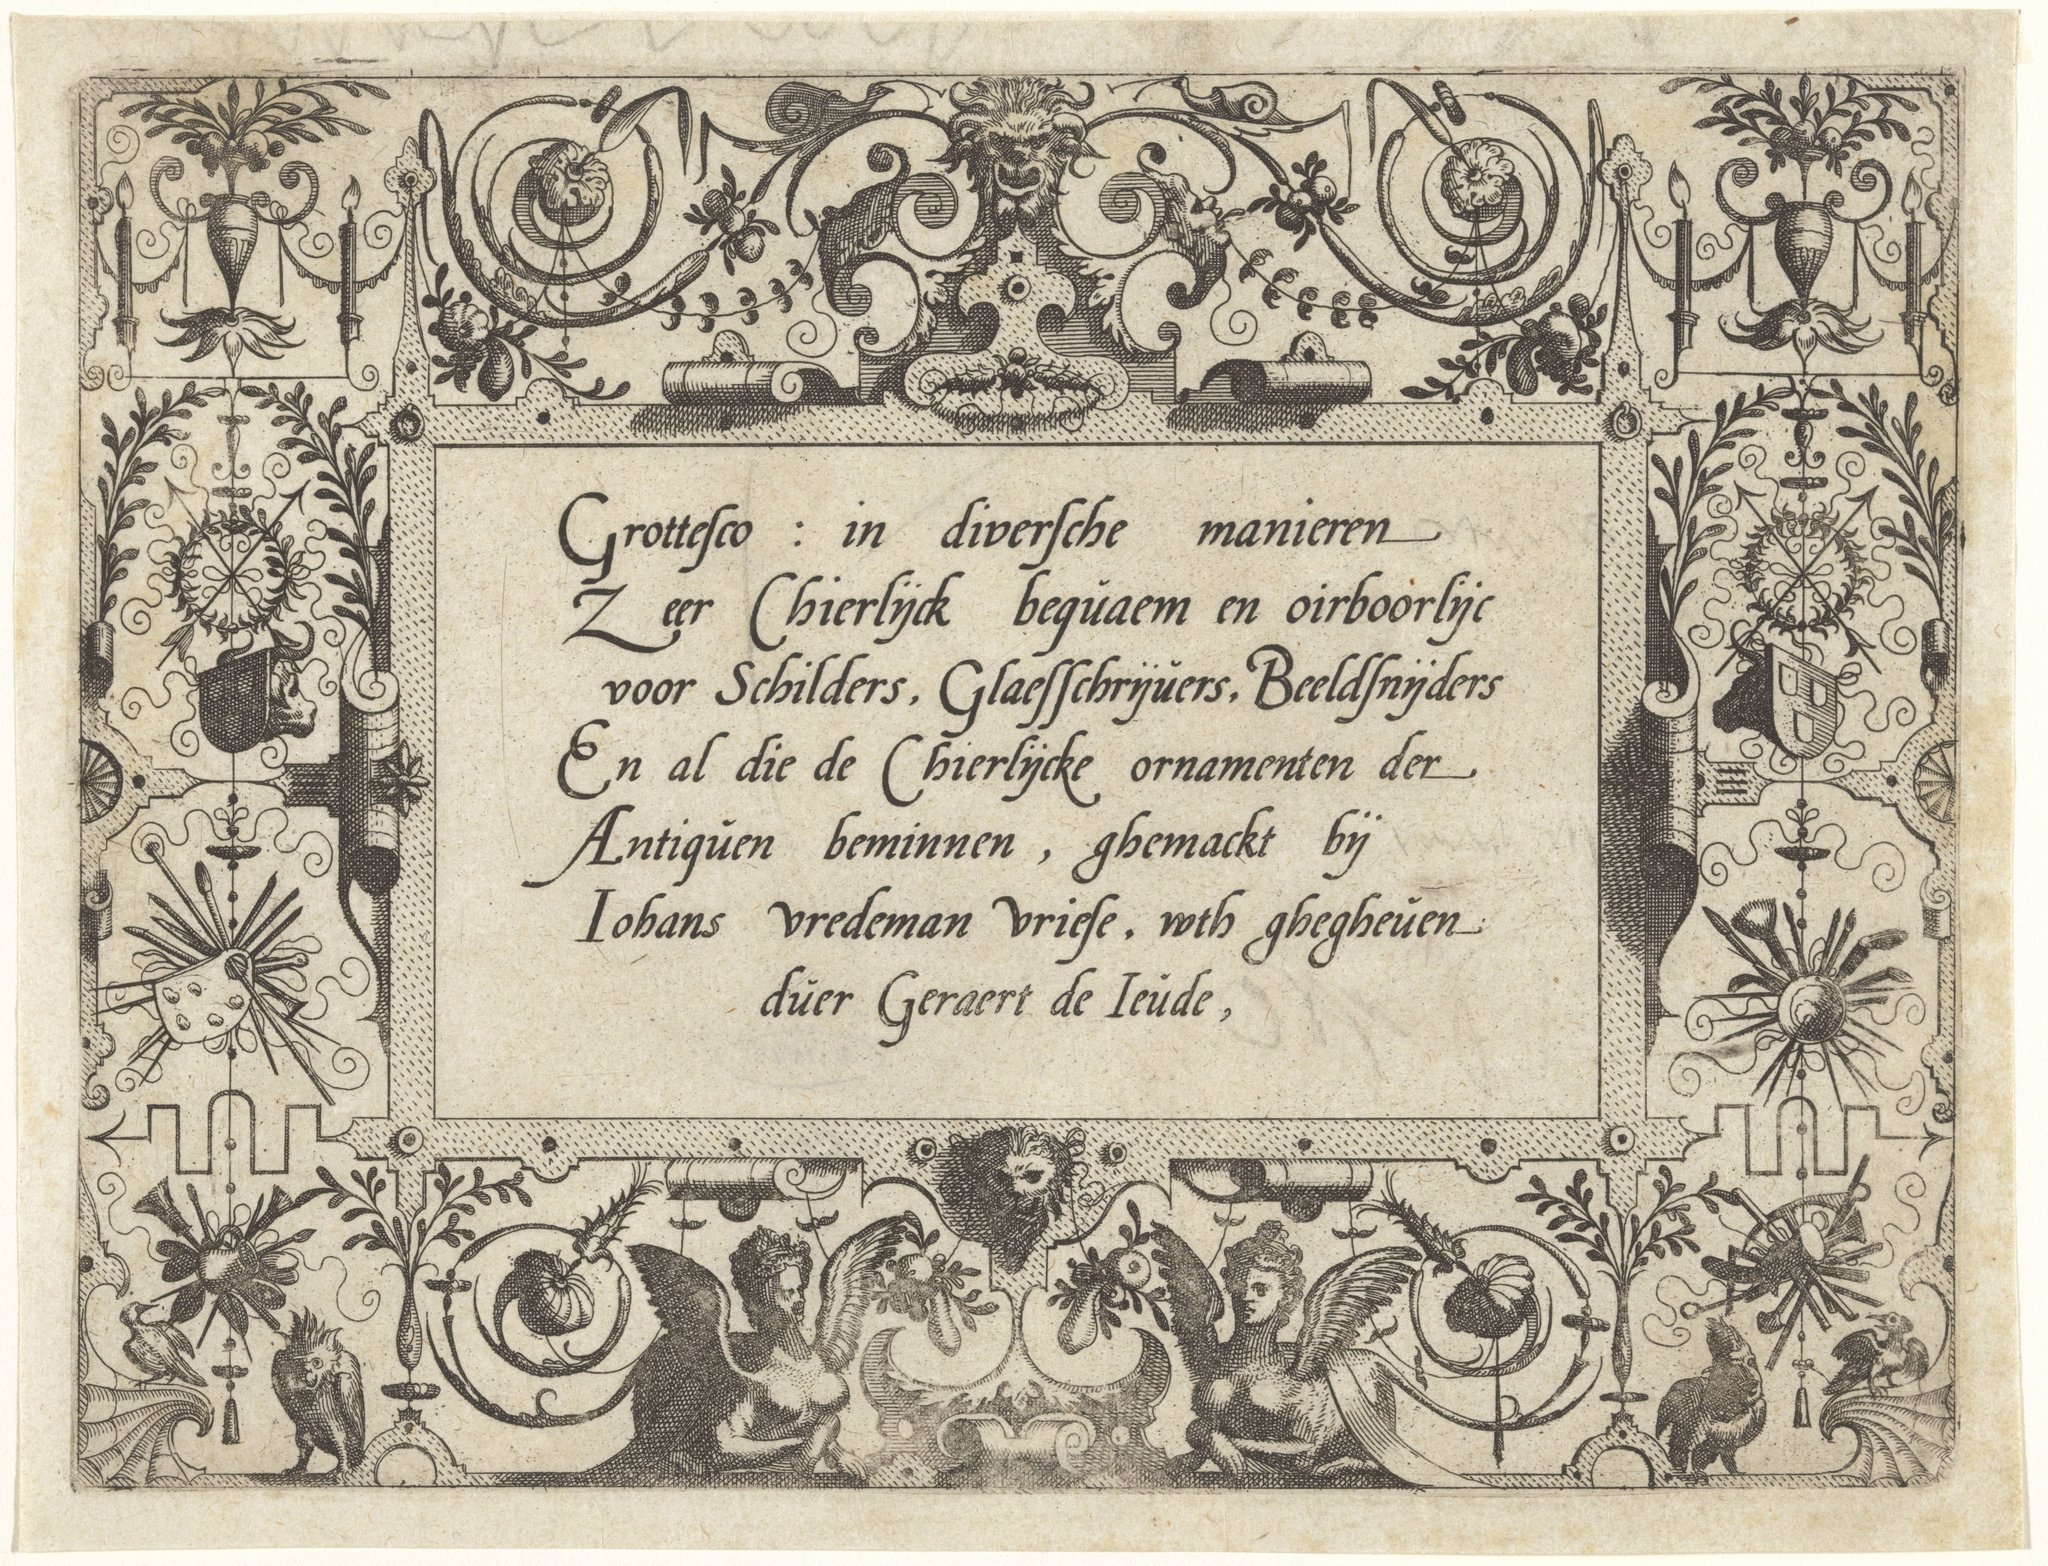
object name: titelblad, titelpagina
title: Grottesco: in diversche manieren…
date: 1565-1571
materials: paper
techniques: etching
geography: netherlands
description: Rechthoekige cartouche met daarin de titel. Middenonder liggen twee sfinxen. Titelblad van serie van 16 bladen met cartouches of architectuurfantasieën met een voorstelling in een omlijsting van grotesken met fabelwezens, dieren, guirlandes, trofeeën en mascarons.